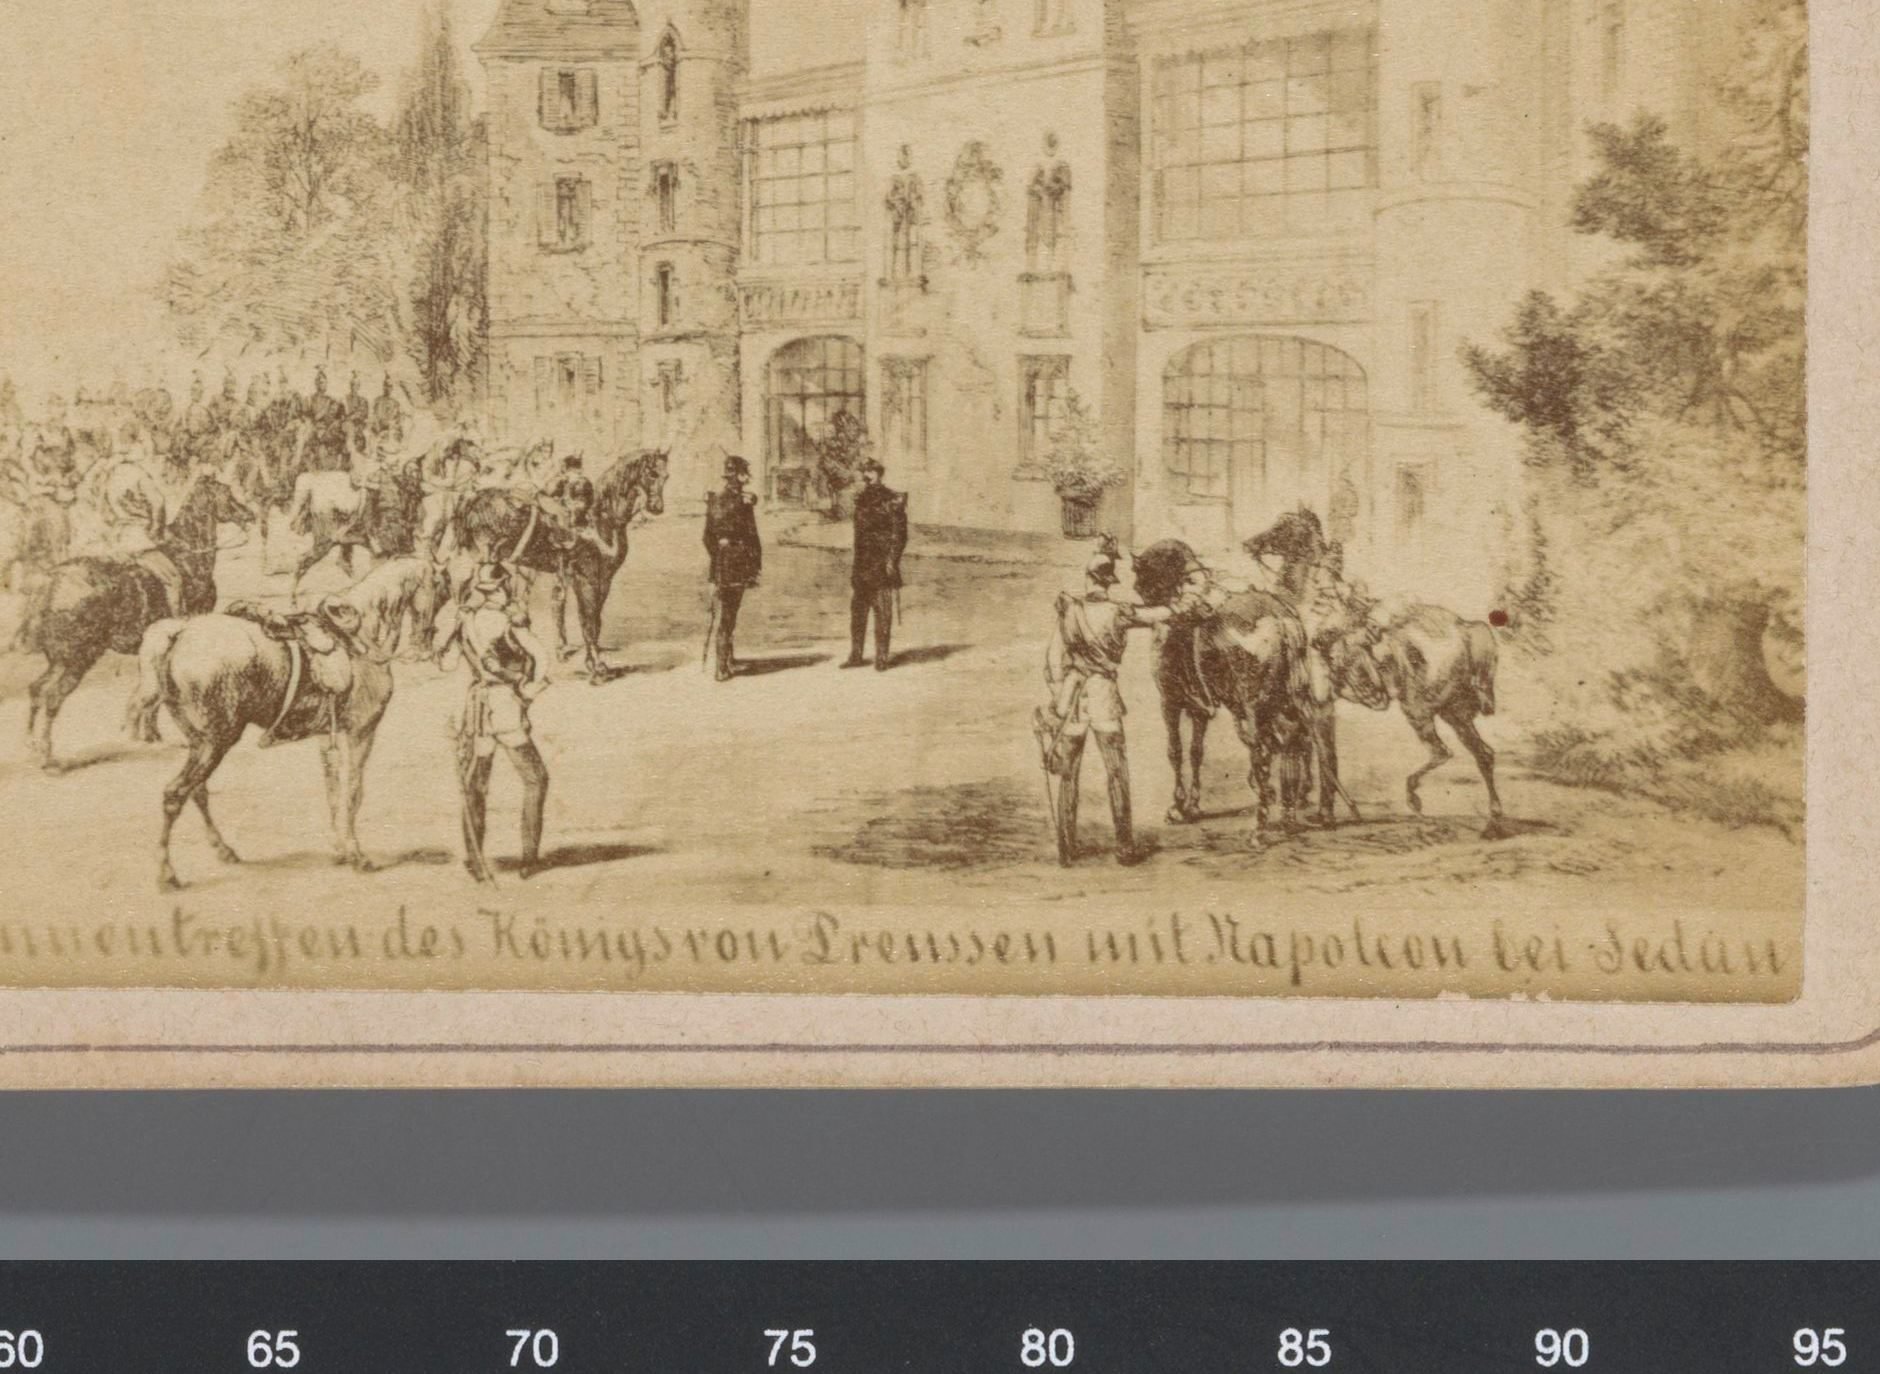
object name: carte de visite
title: Kriegsbilder aus dem Jahre 1870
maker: Anonymous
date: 1870-1890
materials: cardboard, paper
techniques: albumen print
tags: the defeated before the victor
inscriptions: number: ‘199’